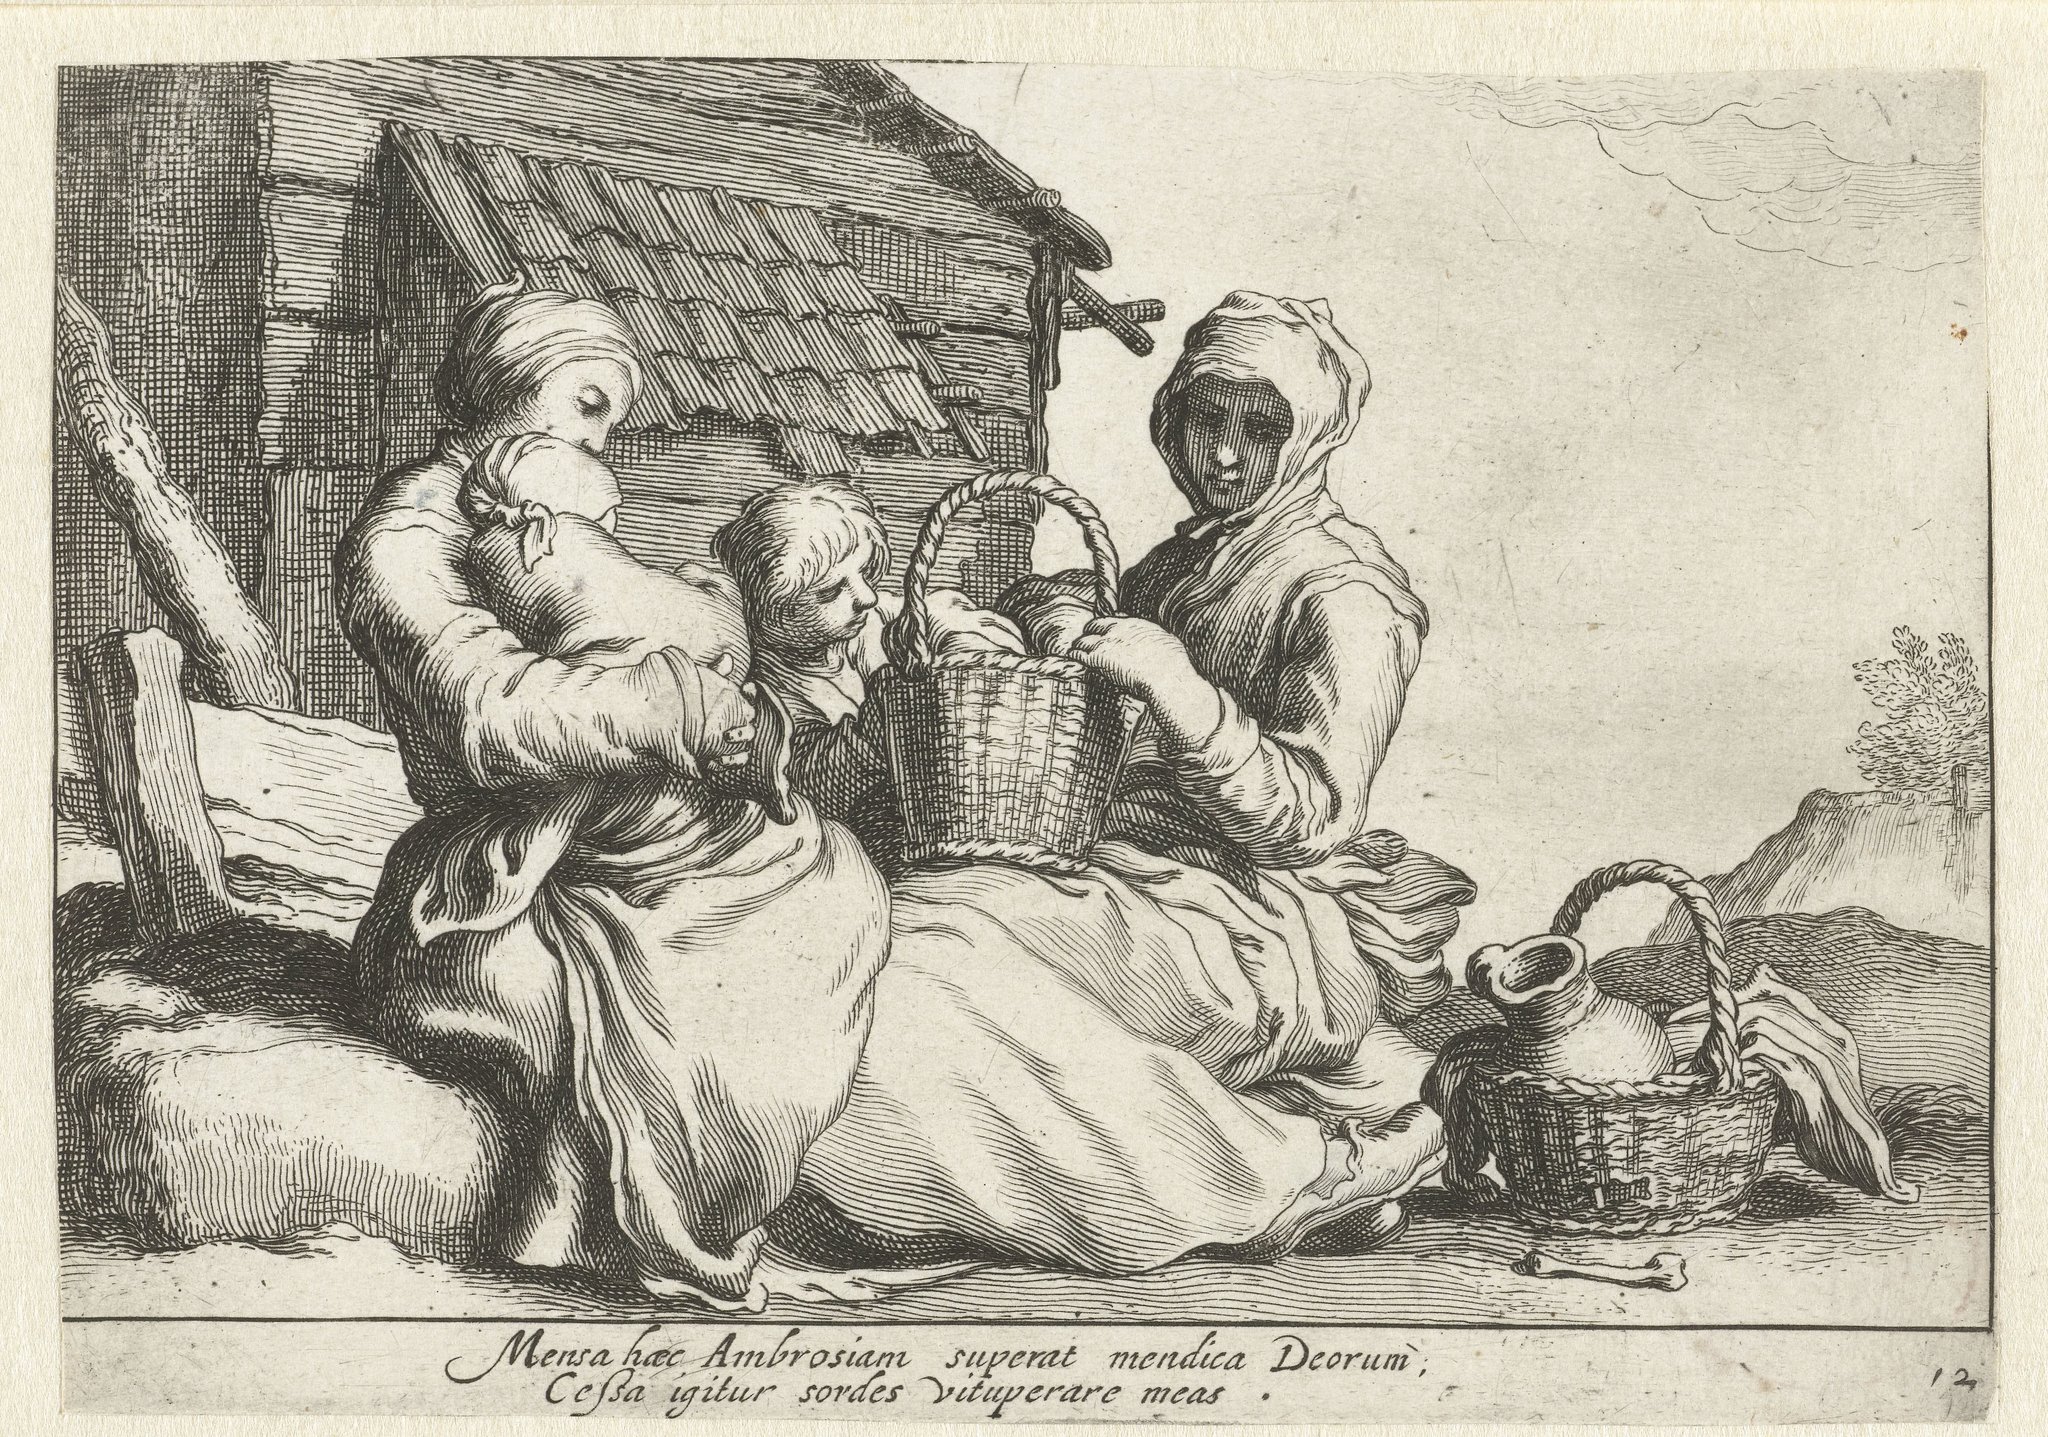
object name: print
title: Twee boerinnen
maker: cornelis bloemaert (ii)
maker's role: draughtsman, print maker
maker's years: 1603-1692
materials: paper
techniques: engraving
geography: utrecht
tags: pastorals, arcadian scenes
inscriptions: collector's mark: Lugt 240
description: Twee vrouwen zitten samen uit te rusten. Een vrouw houdt een baby in haar arm, een jongen grijpt in de mand die de tweede vrouw op haar schoot heeft. Met tweeregelig Latijns onderschrift.